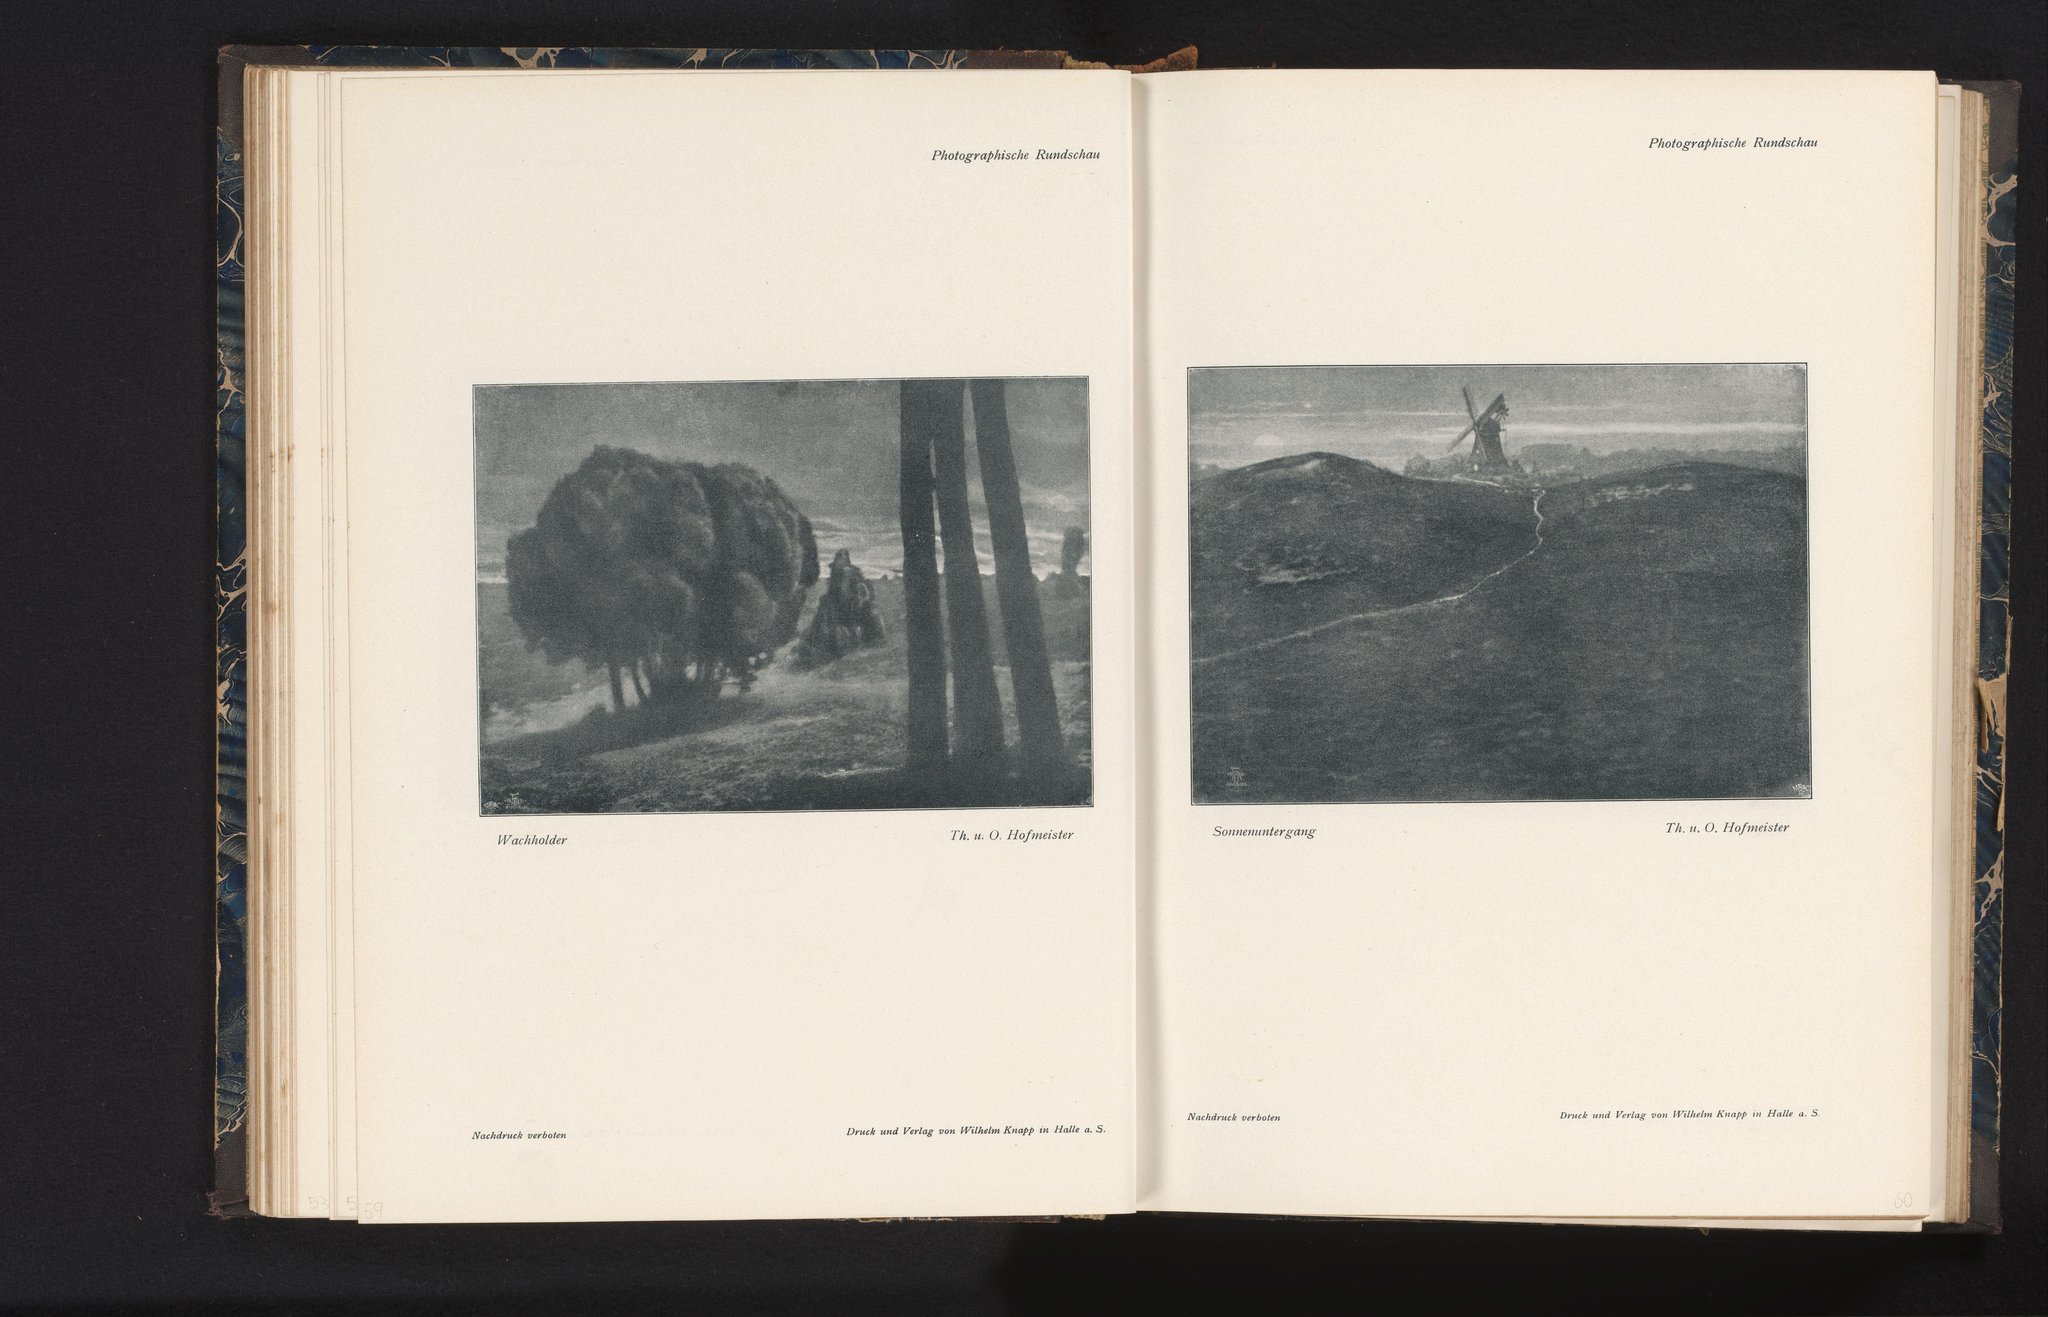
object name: photomechanical print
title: Gezicht op een aantal bomen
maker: th. u. o. hofmeister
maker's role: fotograaf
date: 1897-1902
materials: paper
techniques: autotype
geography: berlin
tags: trees, landscapes